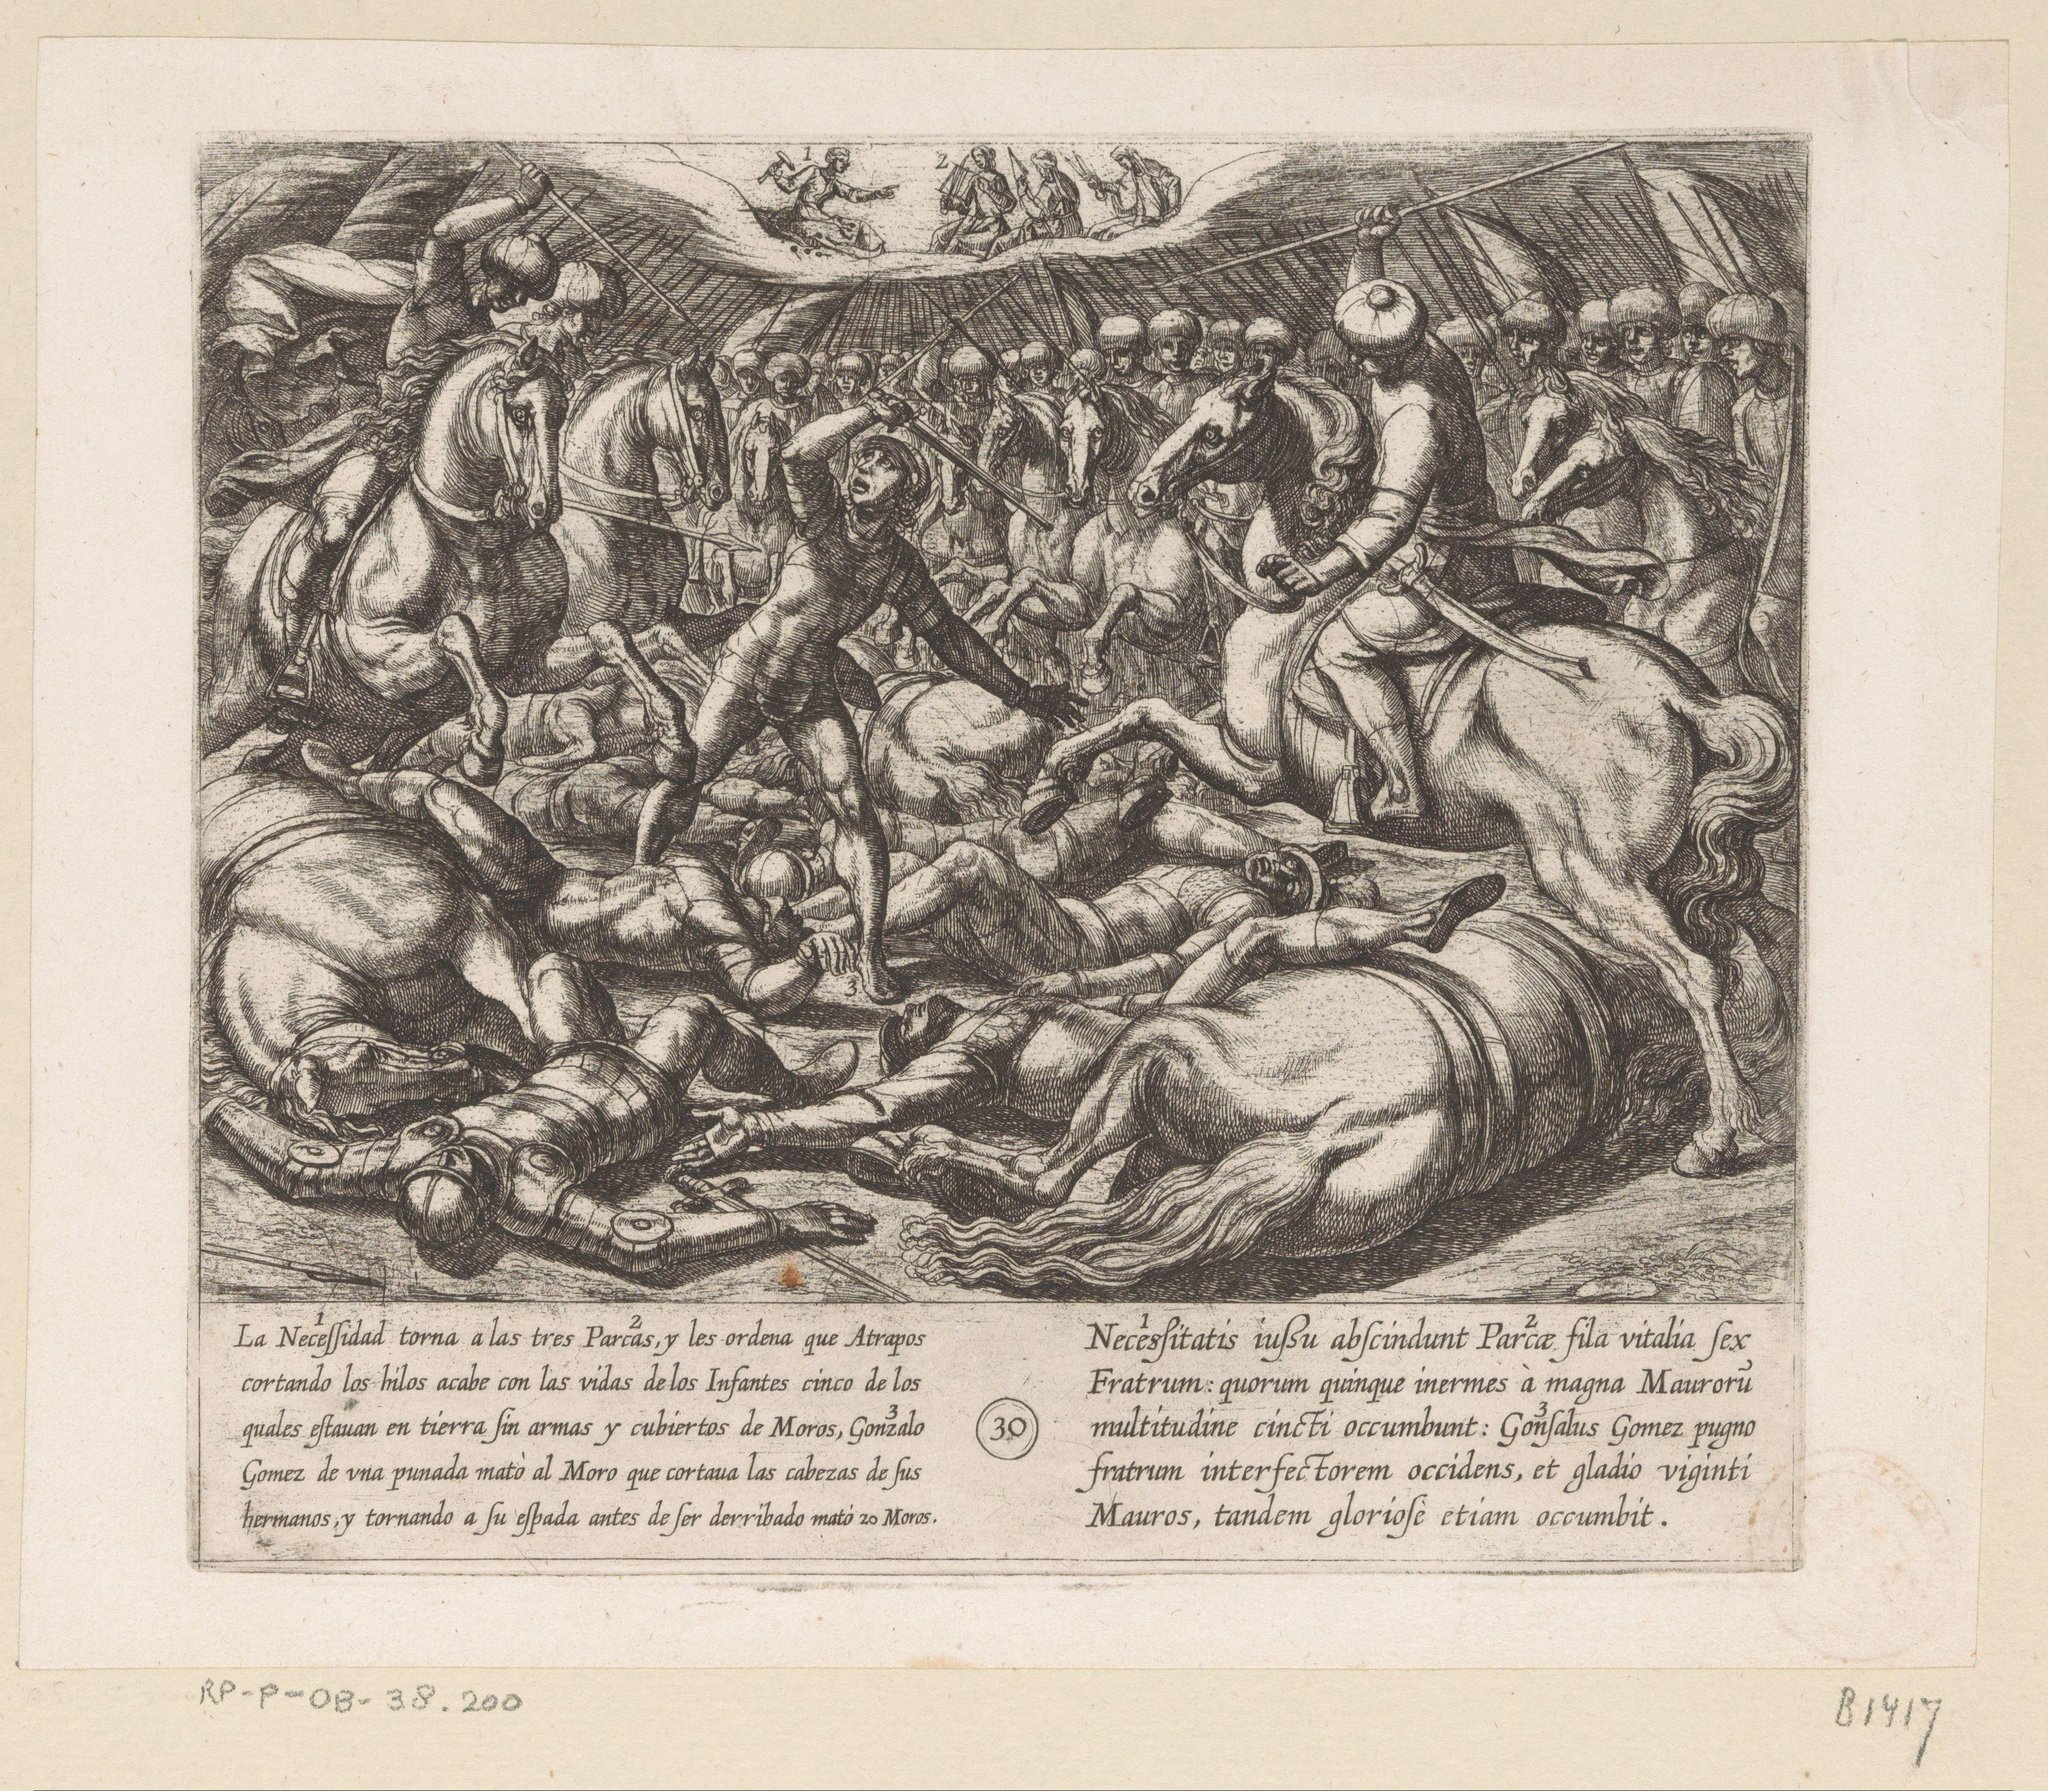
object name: print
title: De zeven infanten van Lara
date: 1612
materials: paper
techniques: etching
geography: italy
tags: battle, warfare; military affairs (+ cavalry, horsemen), tales and fairy tales, the soldier; the soldier's life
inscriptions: collector's mark: Lugt 240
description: Deze prent maakt deel uit van een reeks van 40 prenten (+ titelprent) met voorstellingen uit het volksverhaal over de zeven infanten van Lara.